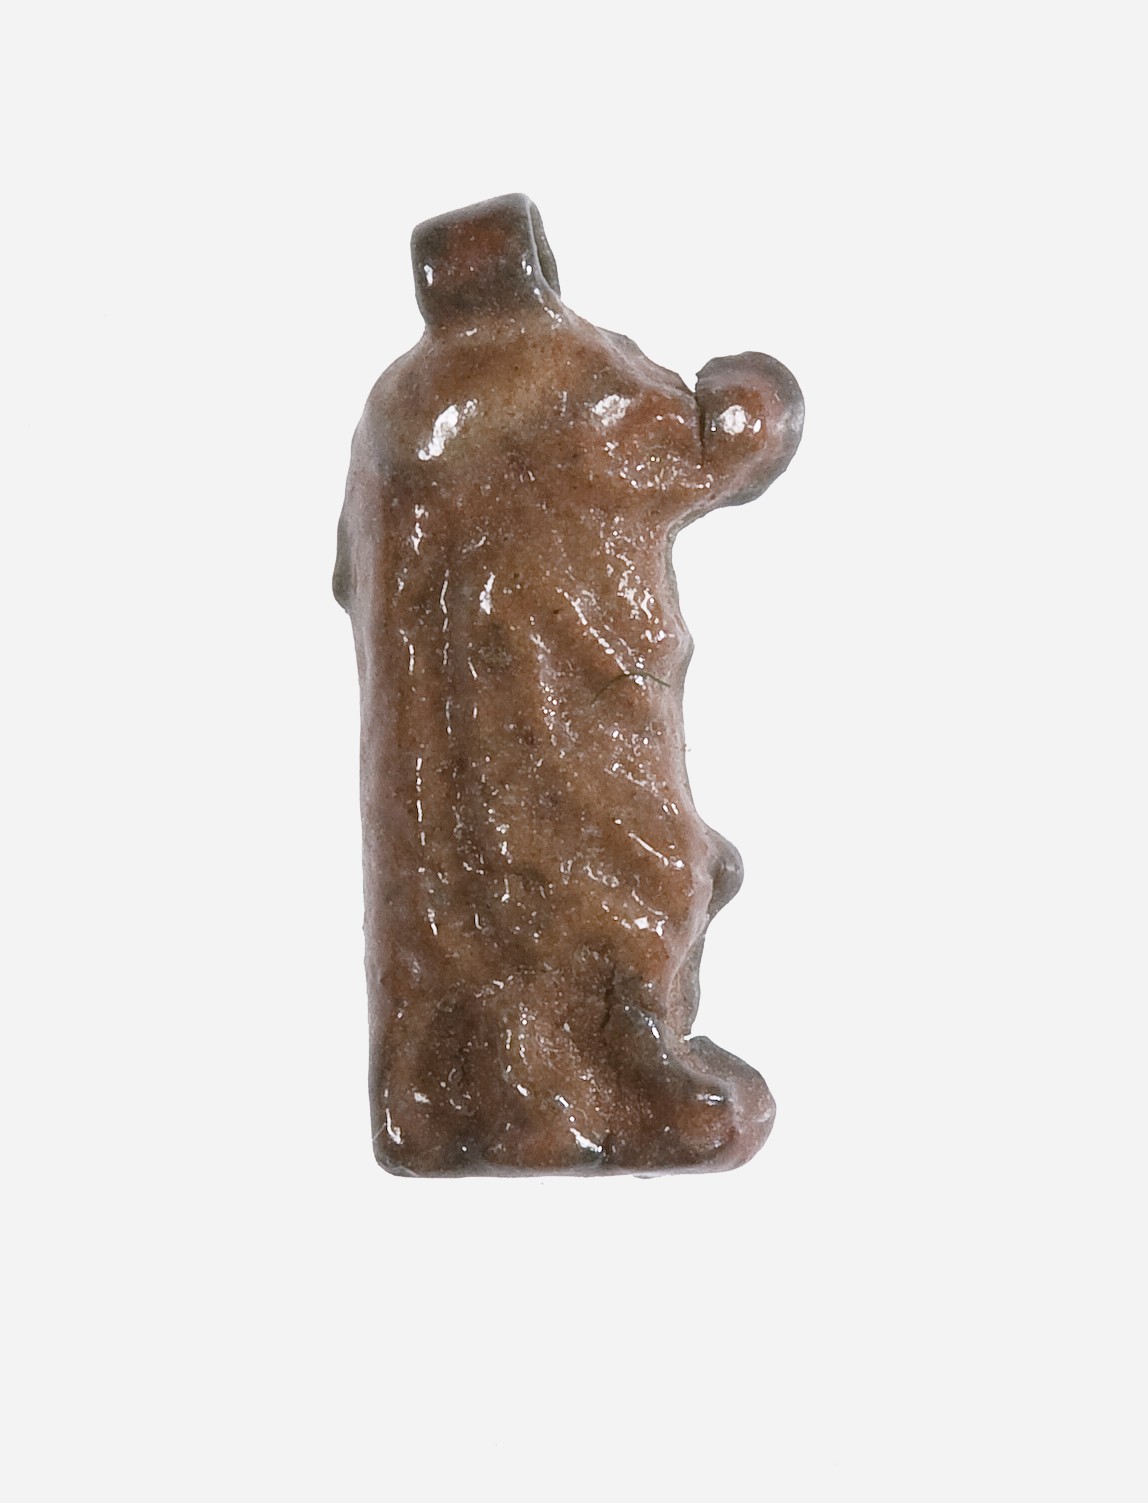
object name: amulet, taweret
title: Taweret Amulet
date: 1390-1352 BCE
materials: faience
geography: egypt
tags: taweret